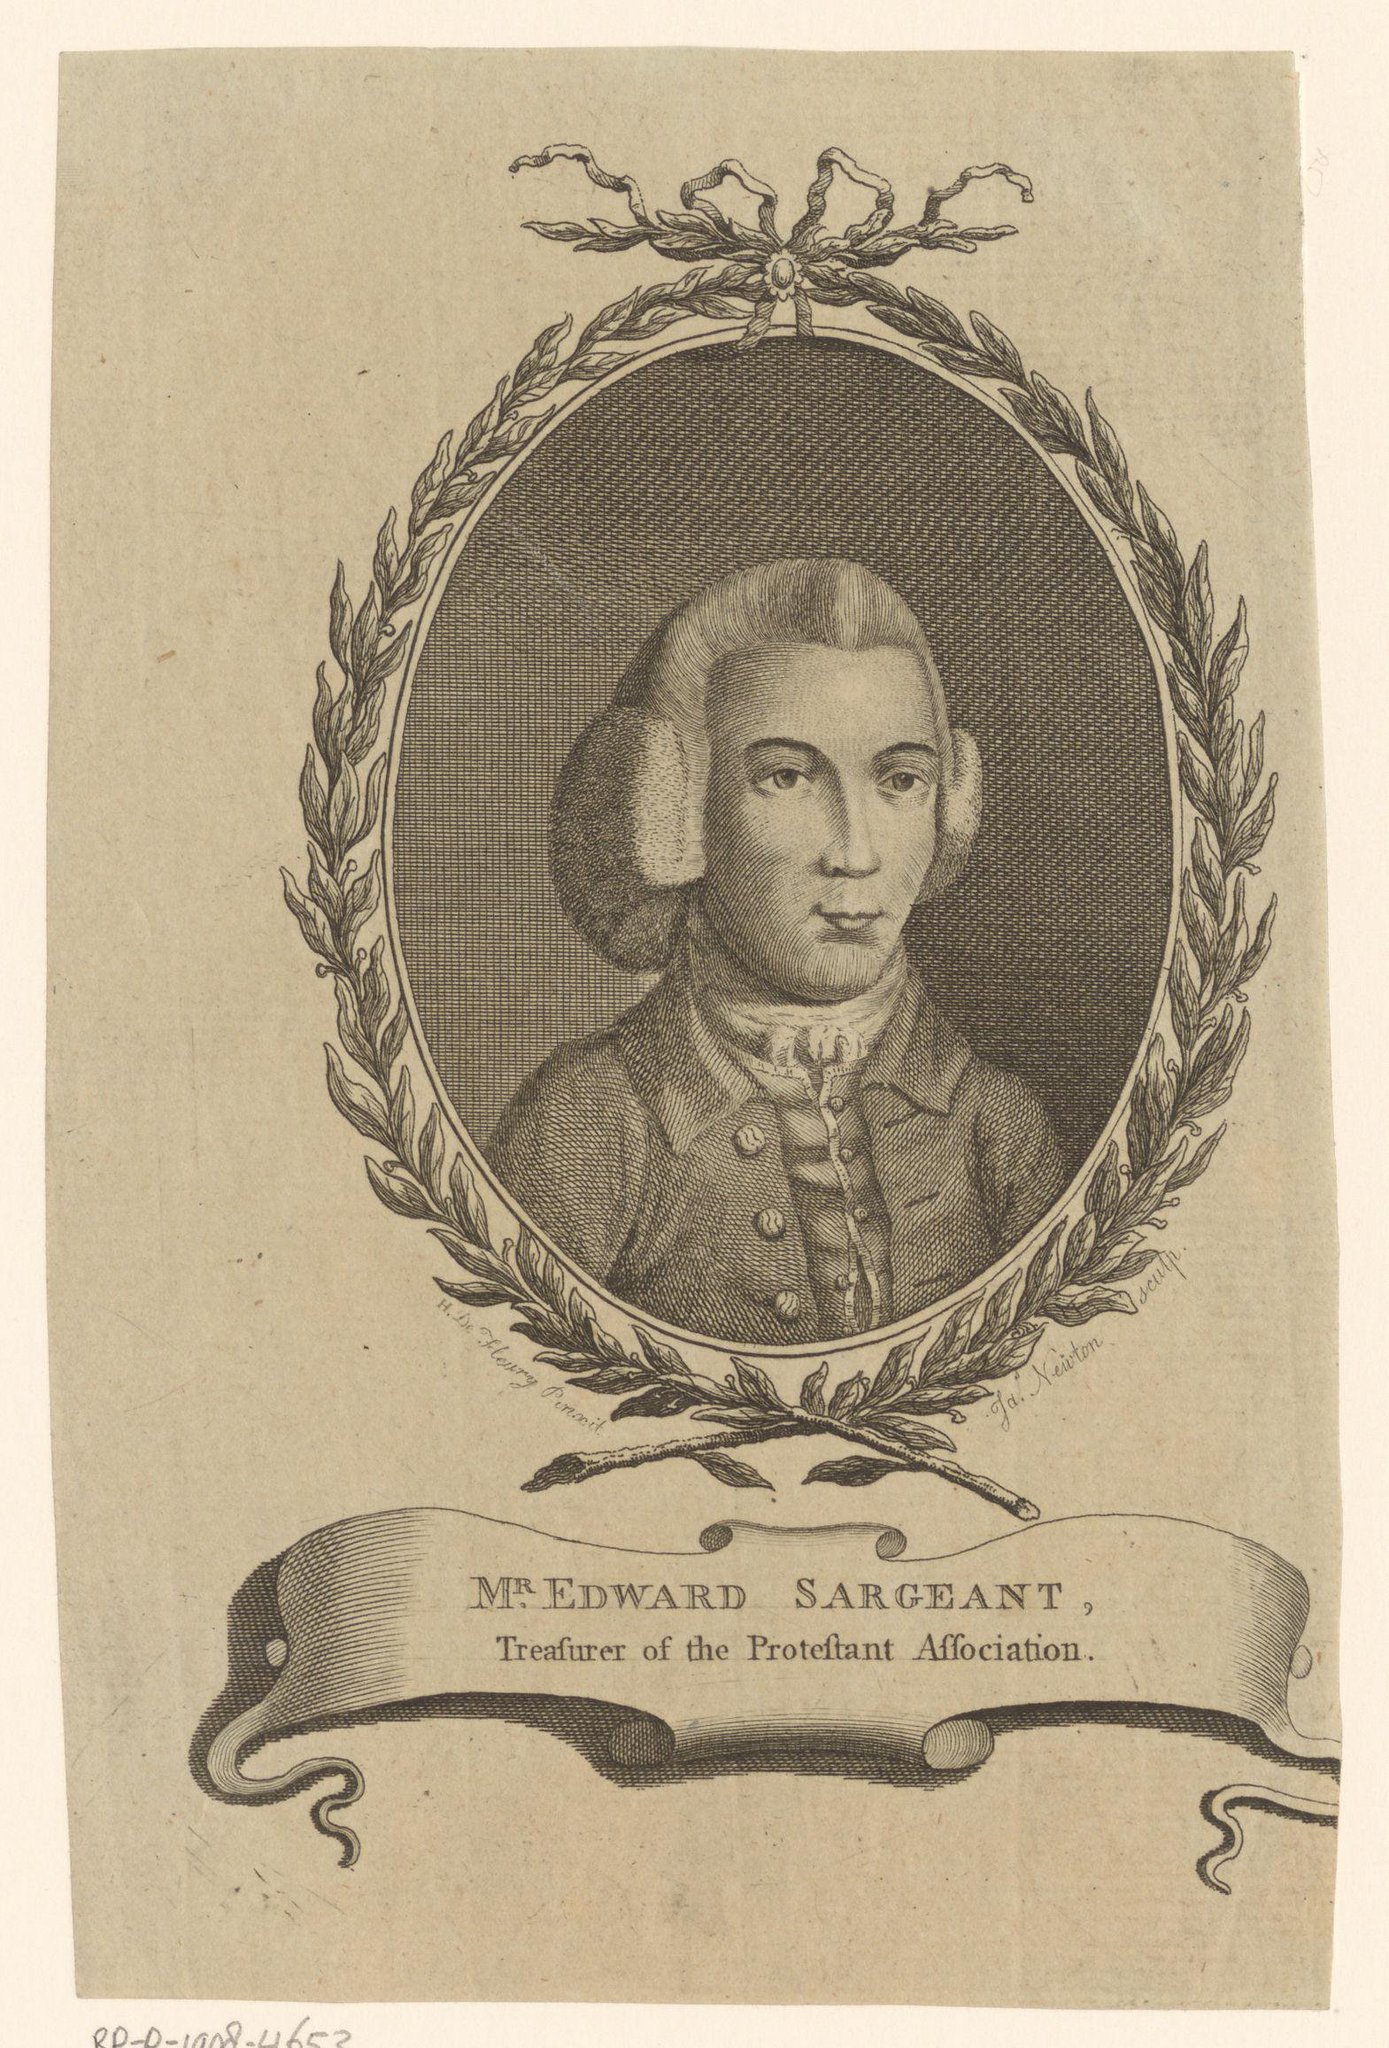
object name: print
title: Mr. Edward Sargeant, Treasurer of the Protestant Association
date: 1770-1804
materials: paper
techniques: engraving, etching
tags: historical persons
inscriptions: collector's mark: Lugt 2228